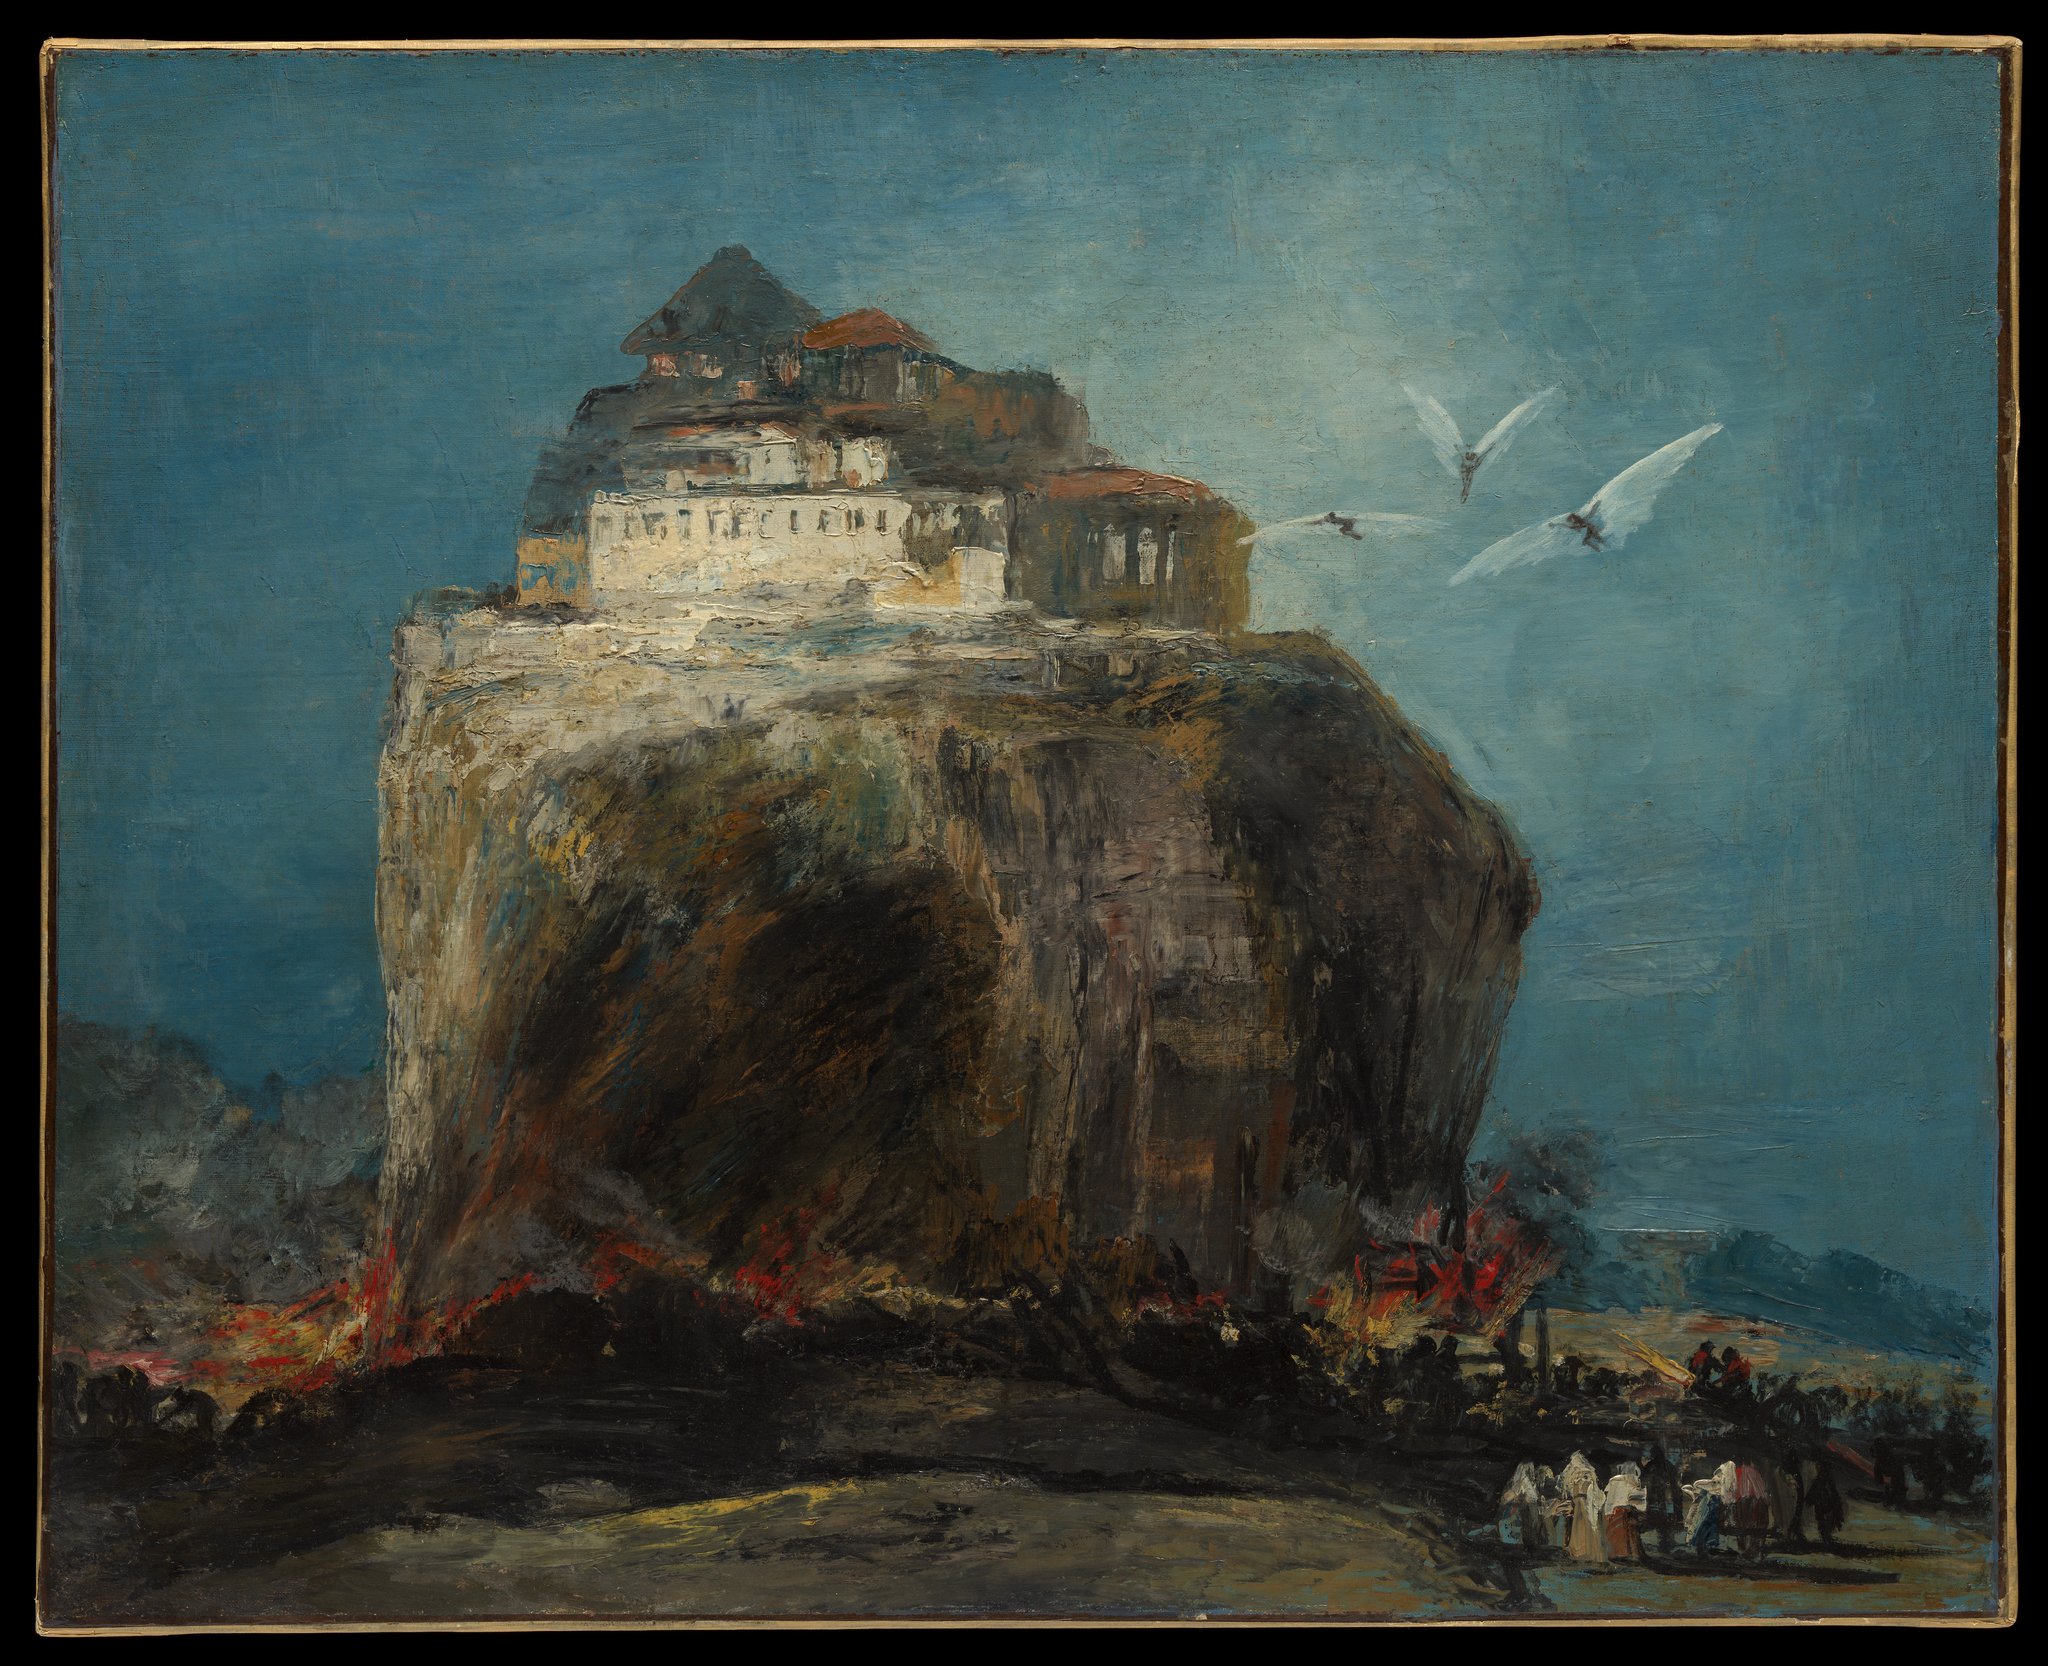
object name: painting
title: A City on a Rock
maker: goya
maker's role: artist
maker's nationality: spanish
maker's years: 1746-1828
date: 1800-1899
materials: canvas, oil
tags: buildings,cities